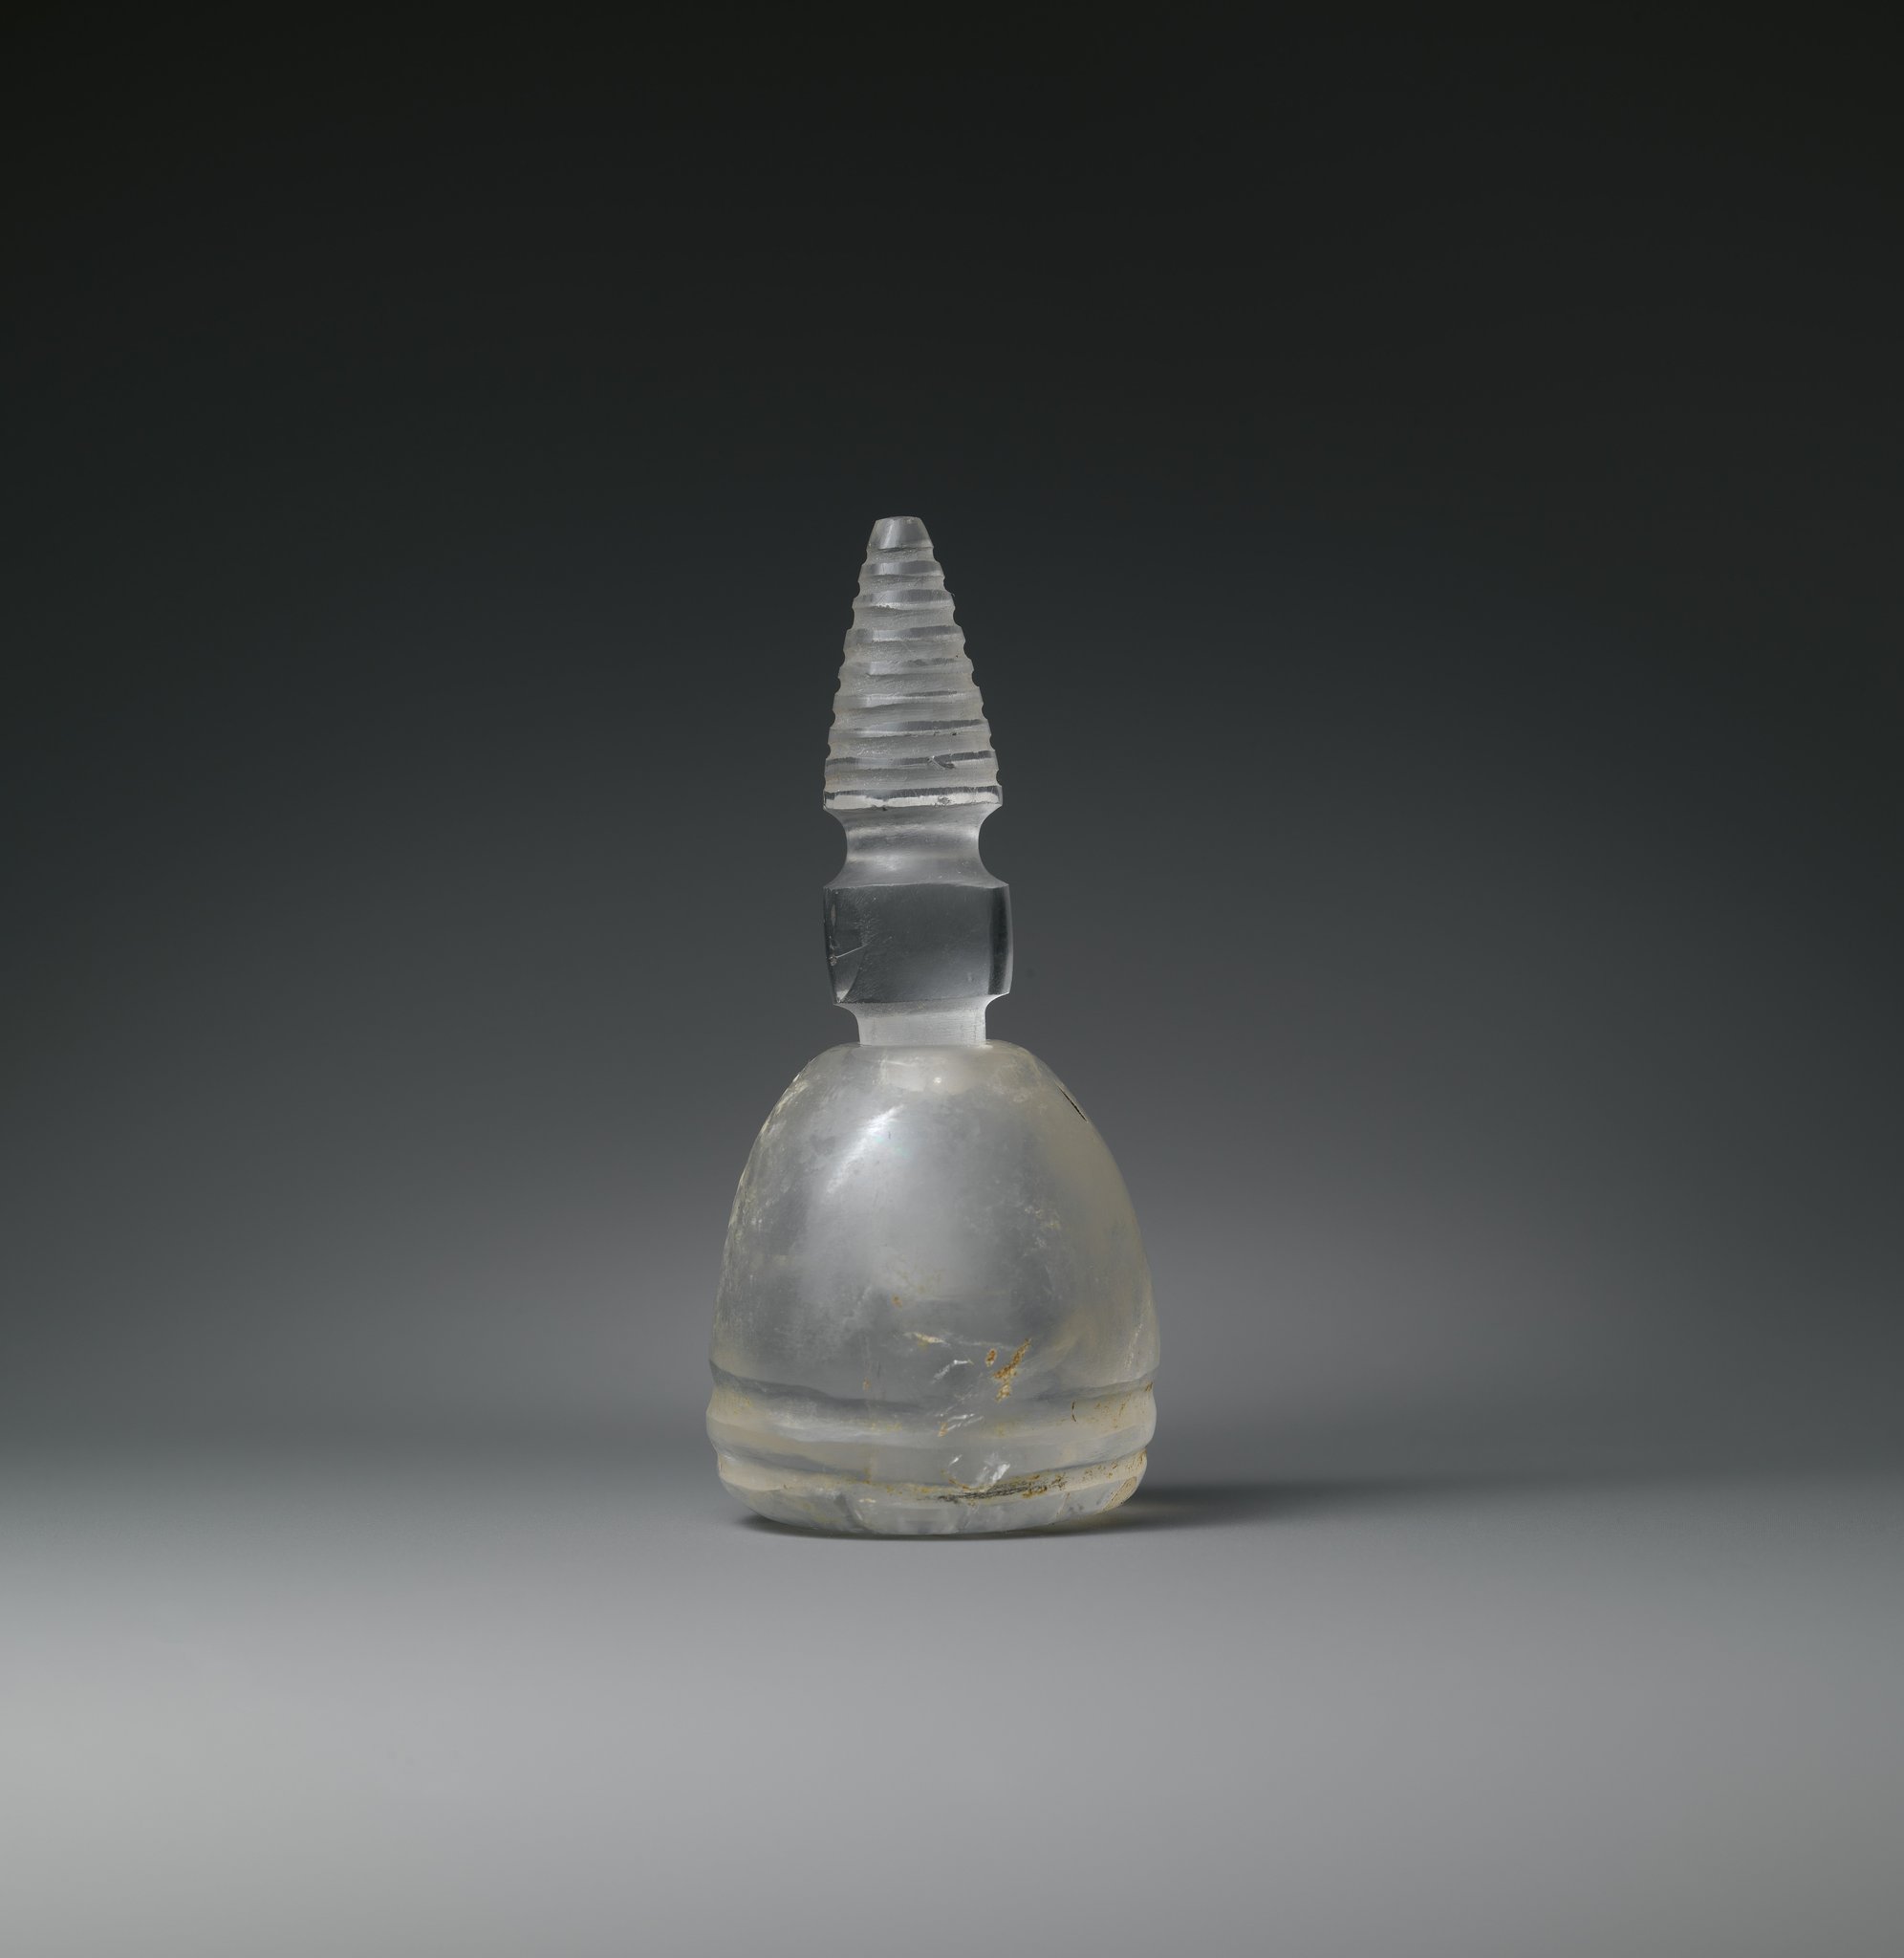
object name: reliquary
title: Reliquary in the shape of a stupa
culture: sri lankan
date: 201-400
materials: quartz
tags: stupas